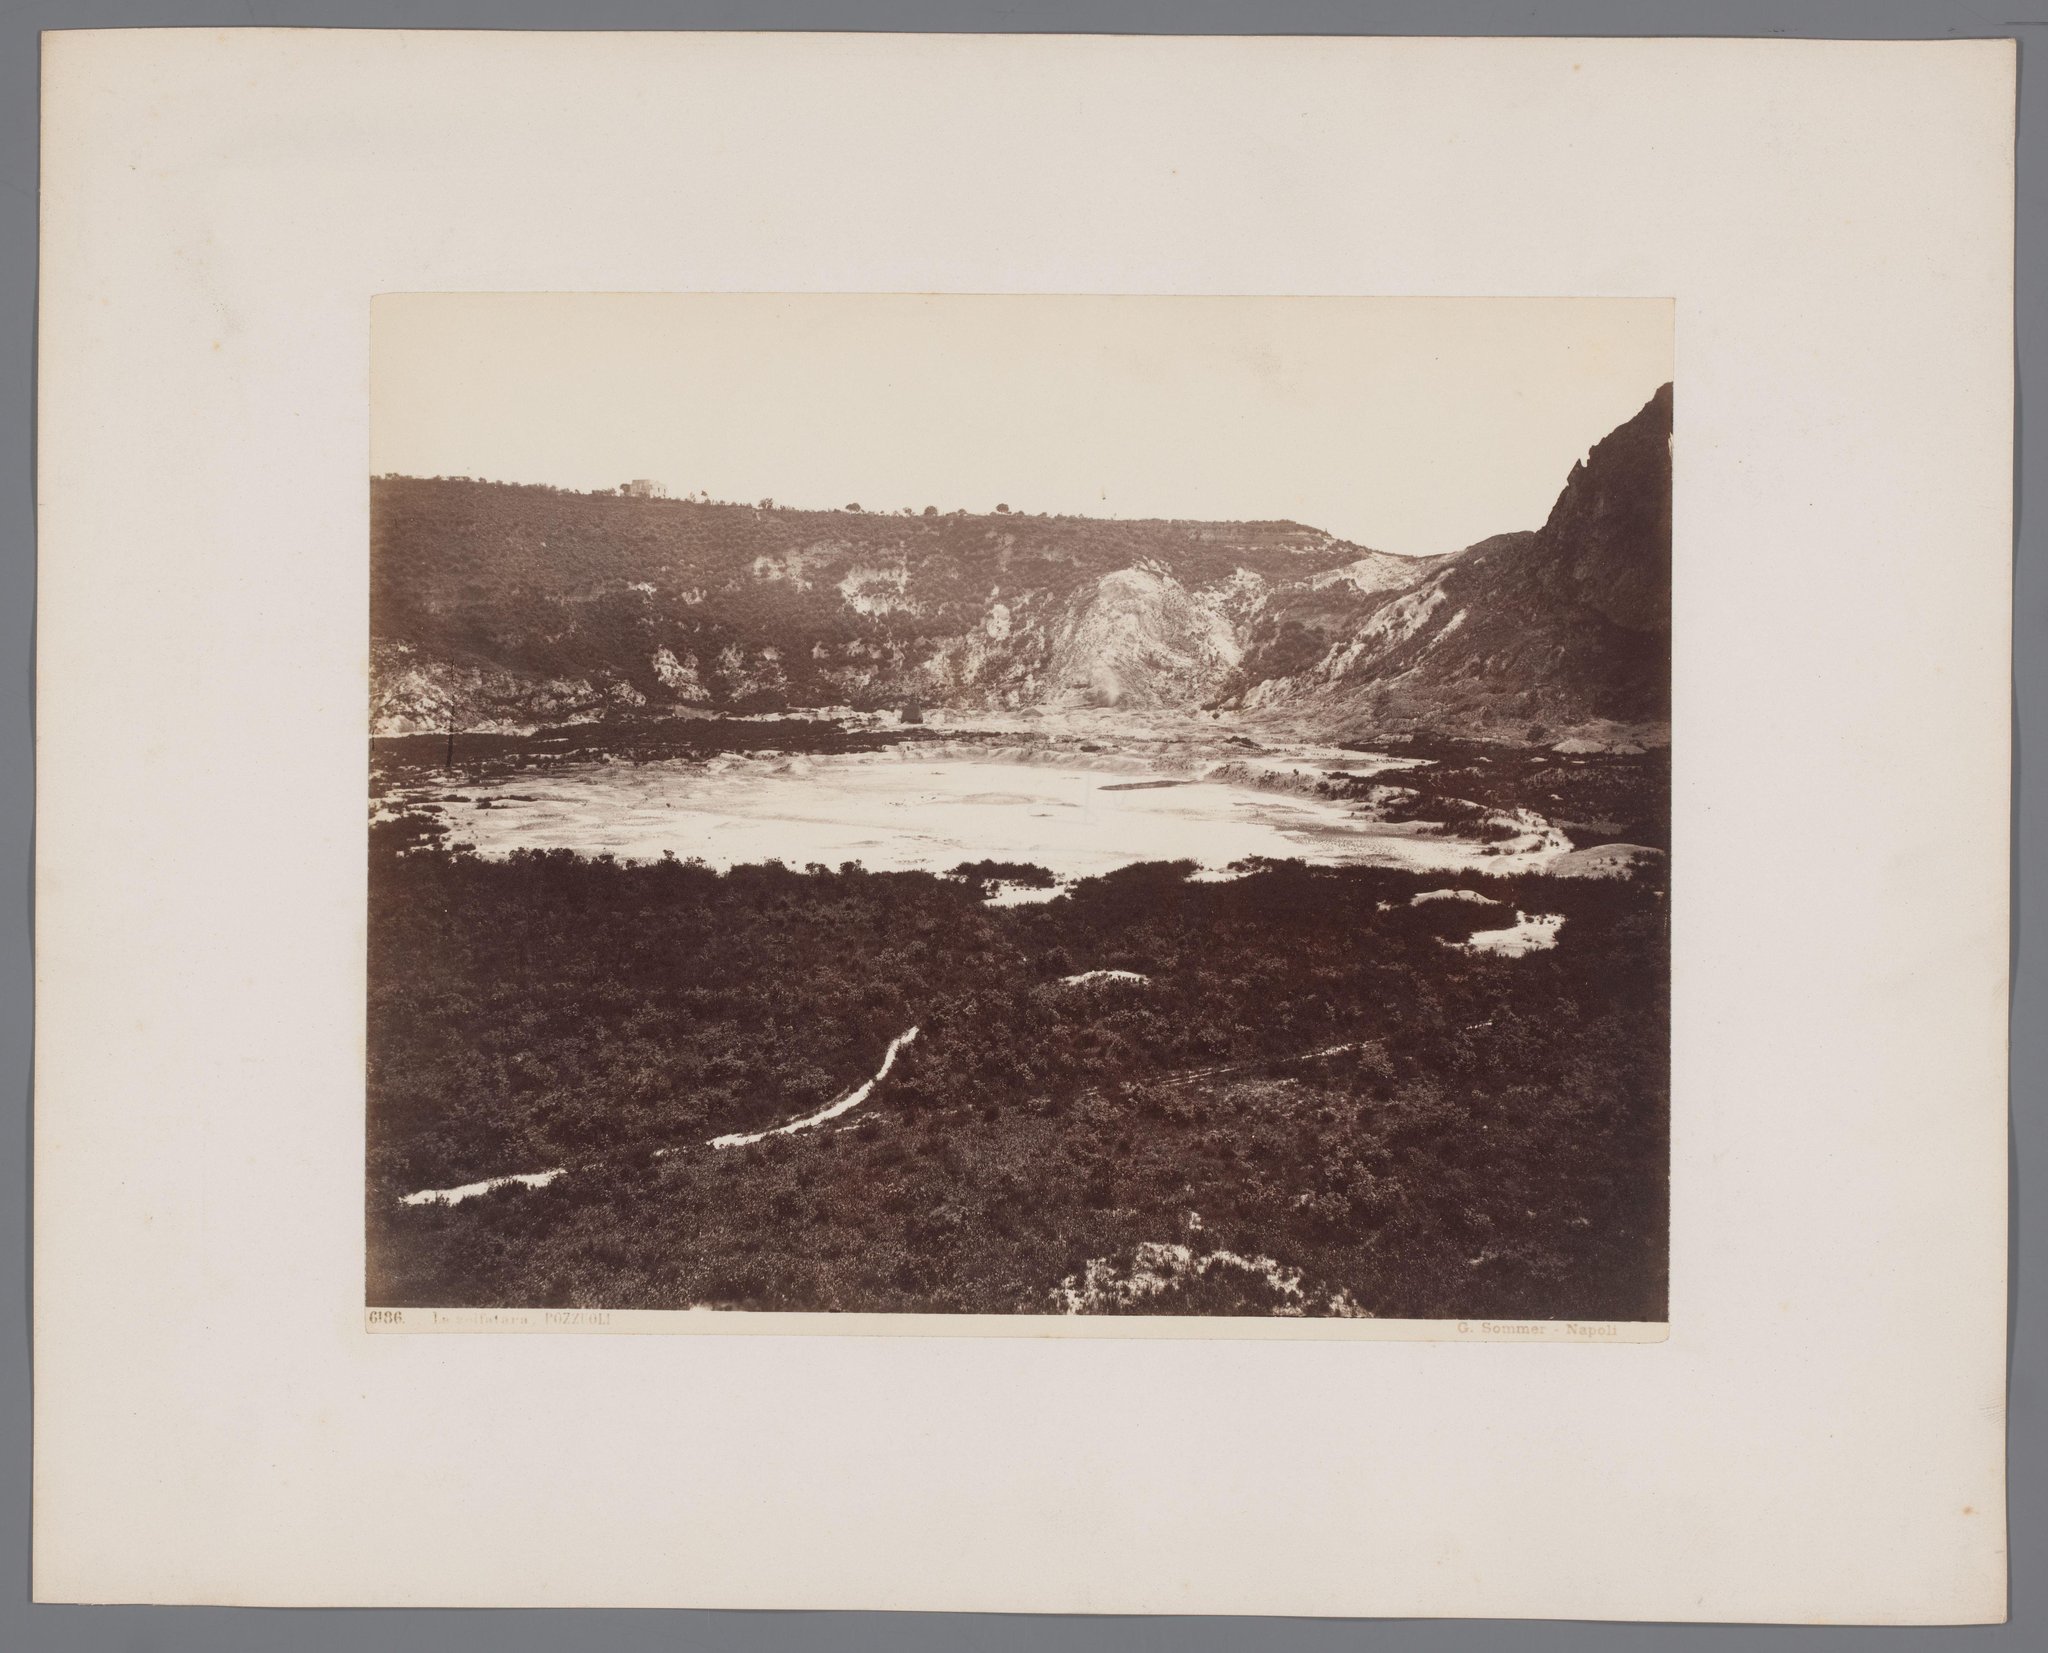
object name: photograph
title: La zolfatara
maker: giorgio sommer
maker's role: fotograaf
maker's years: 1834-1914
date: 1857-1914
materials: cardboard, paper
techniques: albumen print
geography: pozzuoli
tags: volcano, pozzuoli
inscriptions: number: ‘6136.’